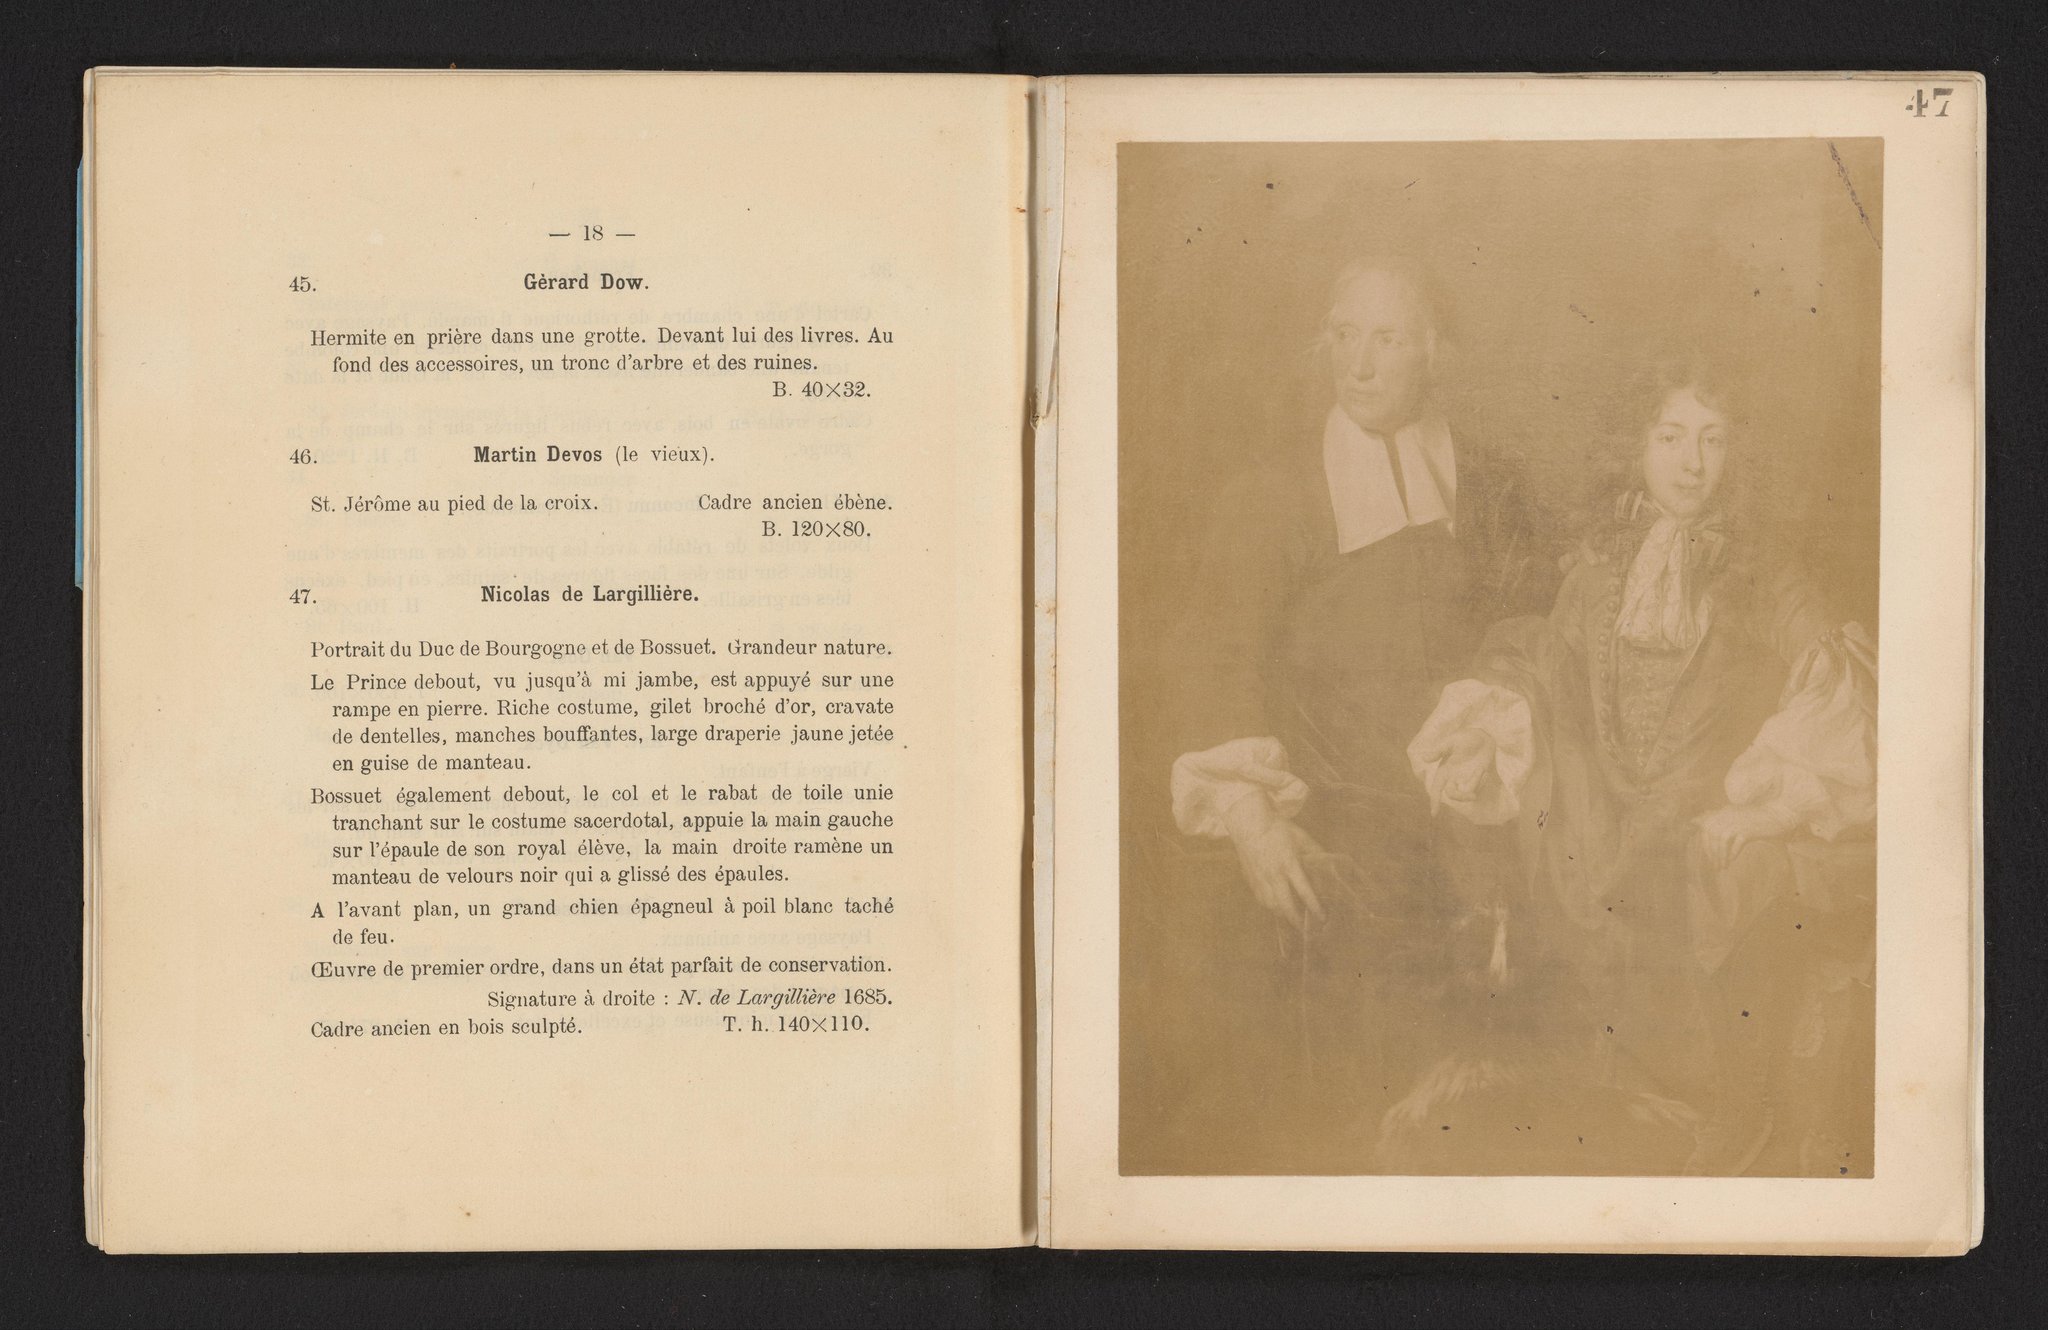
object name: reproduction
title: Fotoreproductie van een schilderij van een portret van Lodewijk, dauphin van Frankrijk en zijn zoon Lodewijk van Frankrijk door Nicolas de Largillière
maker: Anonymous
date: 1882-1887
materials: photographic support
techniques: albumen print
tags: lodewijk van frankrijk (hertog van bourgondië), dauphin van frankrijk lodewijk, aristocracy; 'aristocratia' (ripa), historical persons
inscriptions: number: ‘47’